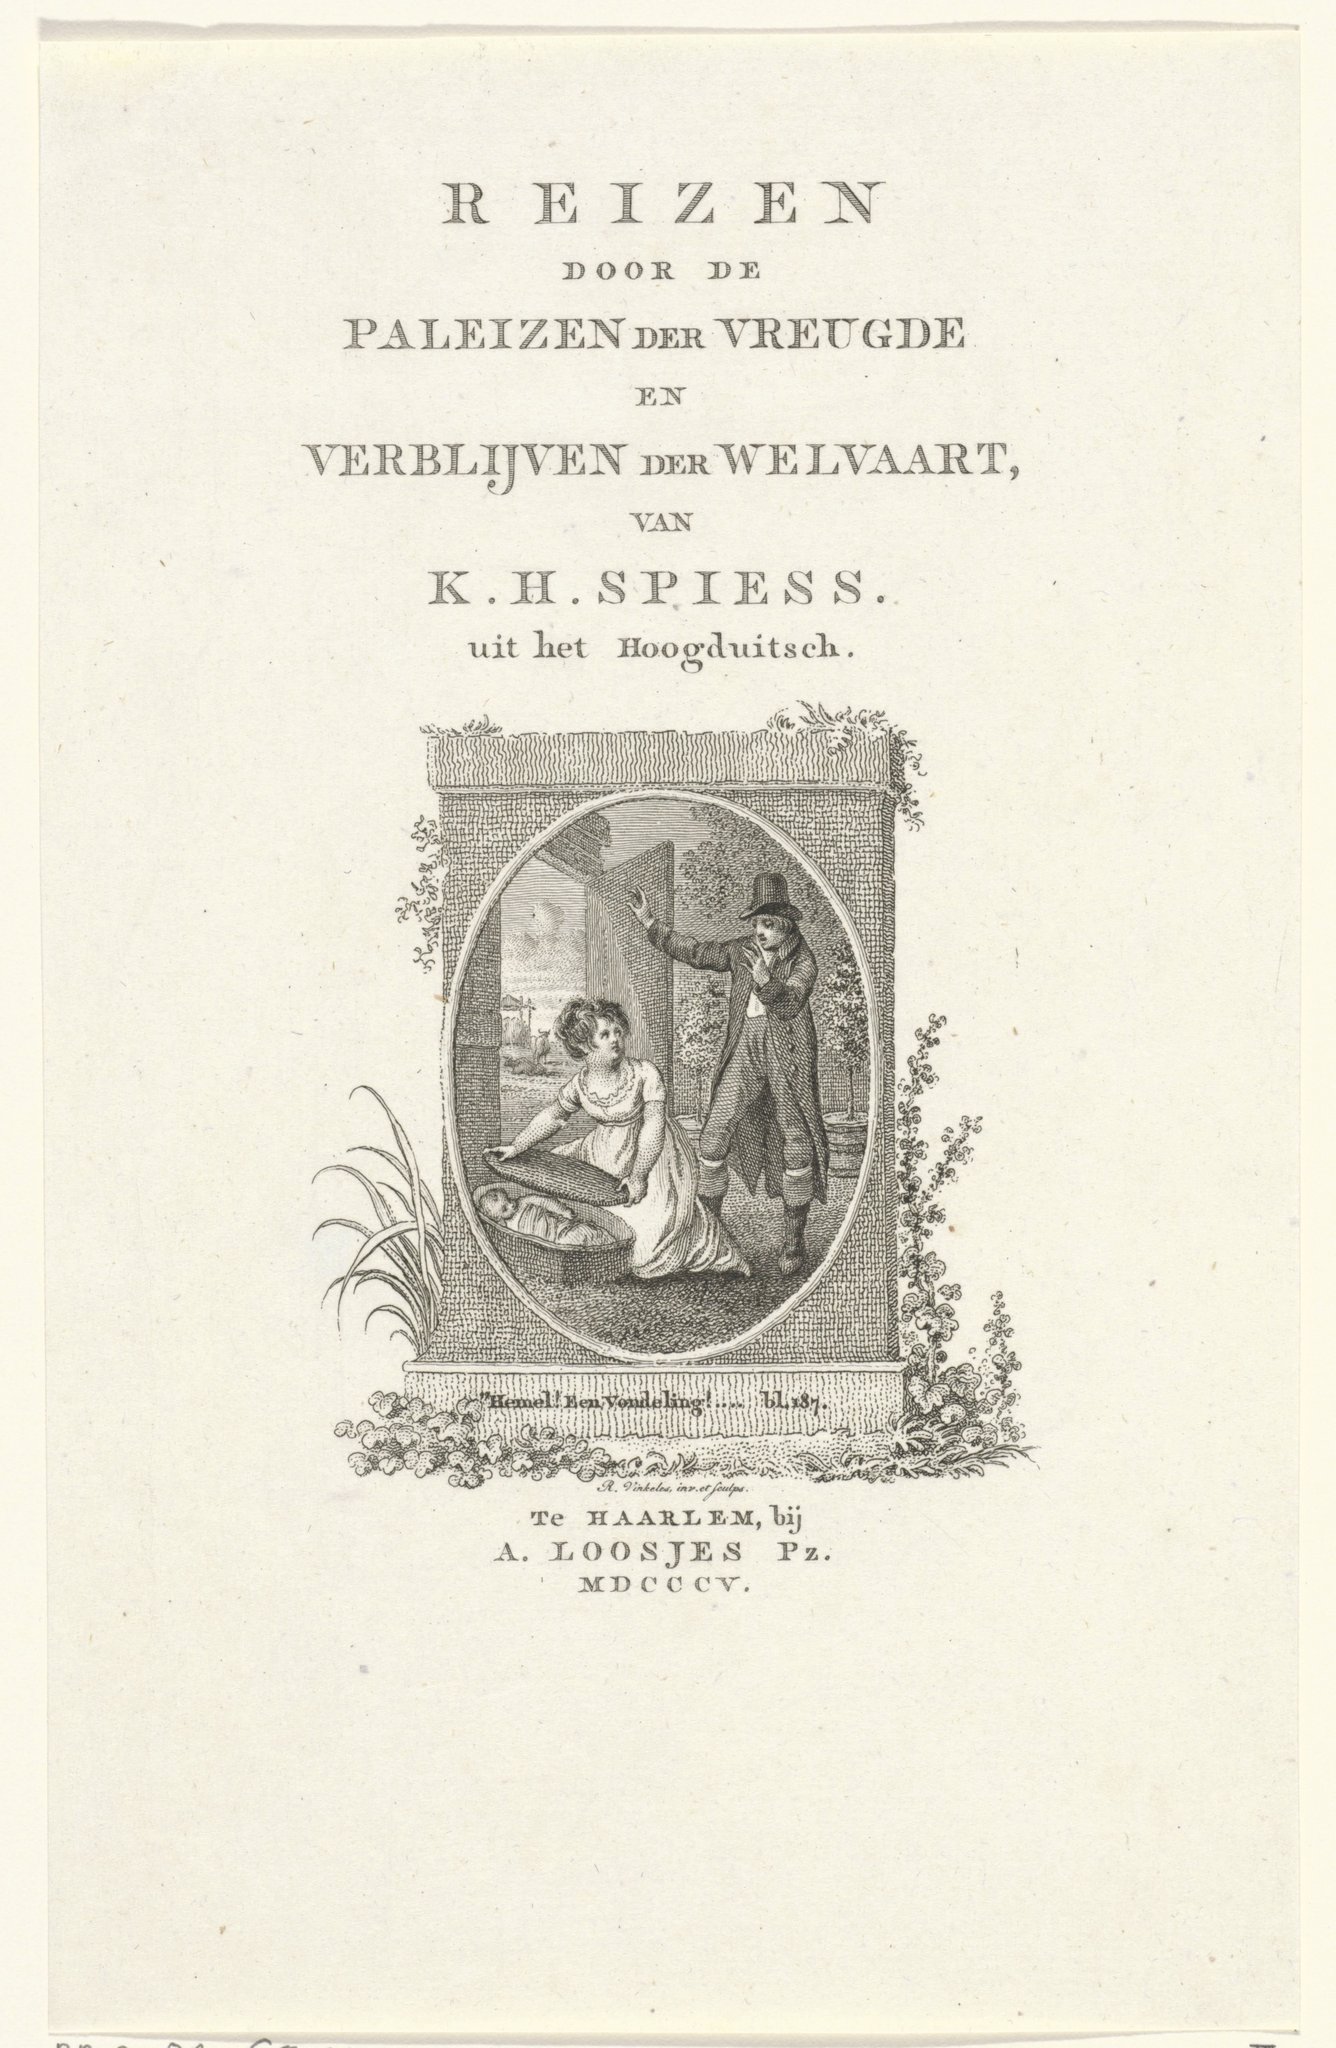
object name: titelblad, titelpagina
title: Titelpagina voor: K.H. Spiess 'Reizen door de Paleizen der Vreugde en Verblijven der Welvaart', 1805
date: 1805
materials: paper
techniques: engraving, etching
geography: haarlem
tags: finding an exposed child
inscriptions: collector's mark: Lugt 240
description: Titelpagina voor: Spiess, K.H. Reizen door de Paleizen der Vreugde en Verblijven der Welvaart. Haarlem: Adriaan Pietersz. Loosjes, 1805.